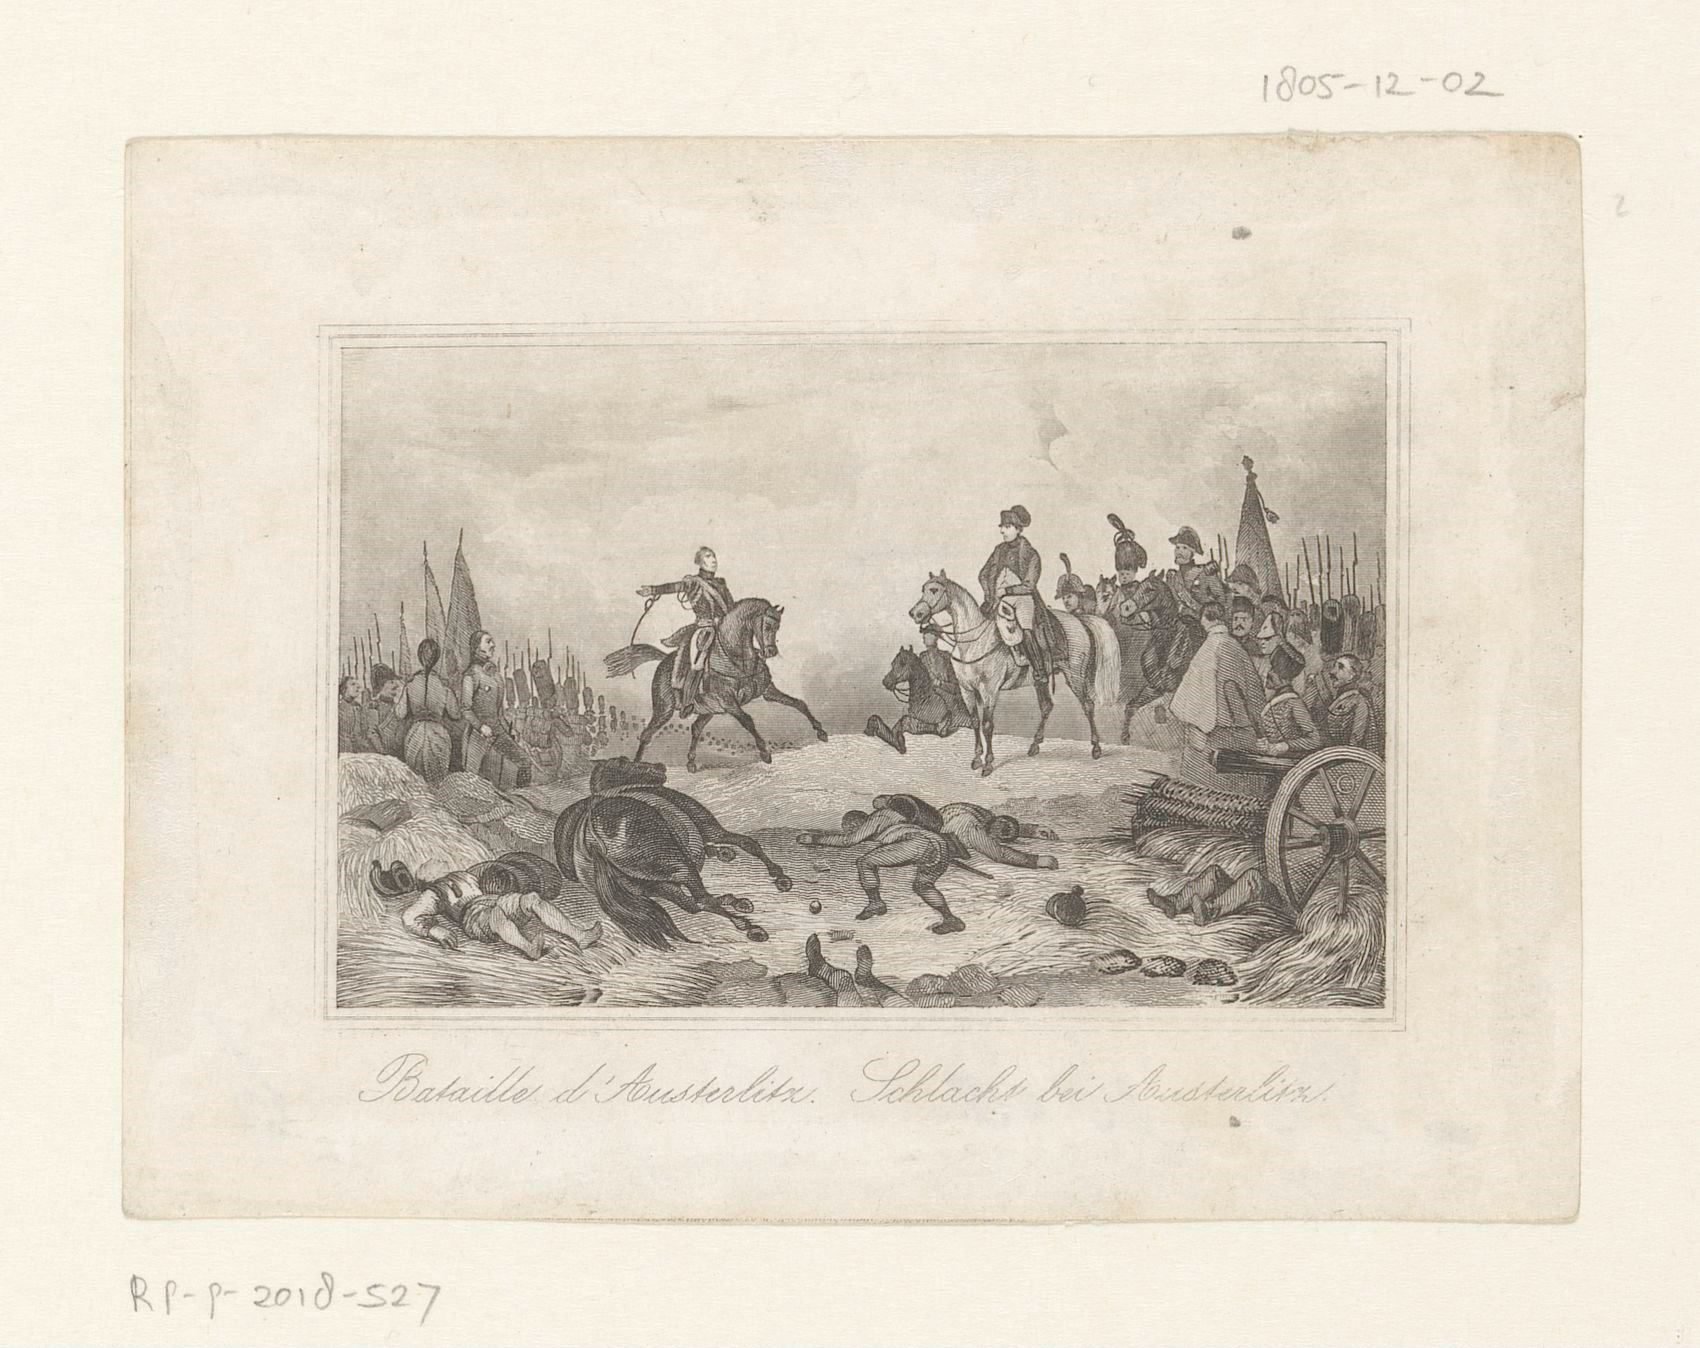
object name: print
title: Slag bij Austerlitz, 1805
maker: Anonymous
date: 1821-1899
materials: paper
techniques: engraving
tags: napoleon i (emperor of the french), battle (+ land forces)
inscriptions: collector's mark: Lugt 2228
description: Overwinning van het Franse leger onder Napoleon tijdens de Slag bij Austerlitz (Slavkov u Brna), 2 december 1805. Onder de voorstelling de titels in het Frans en Duits. Onderdeel van een groep van twaalf illustraties.